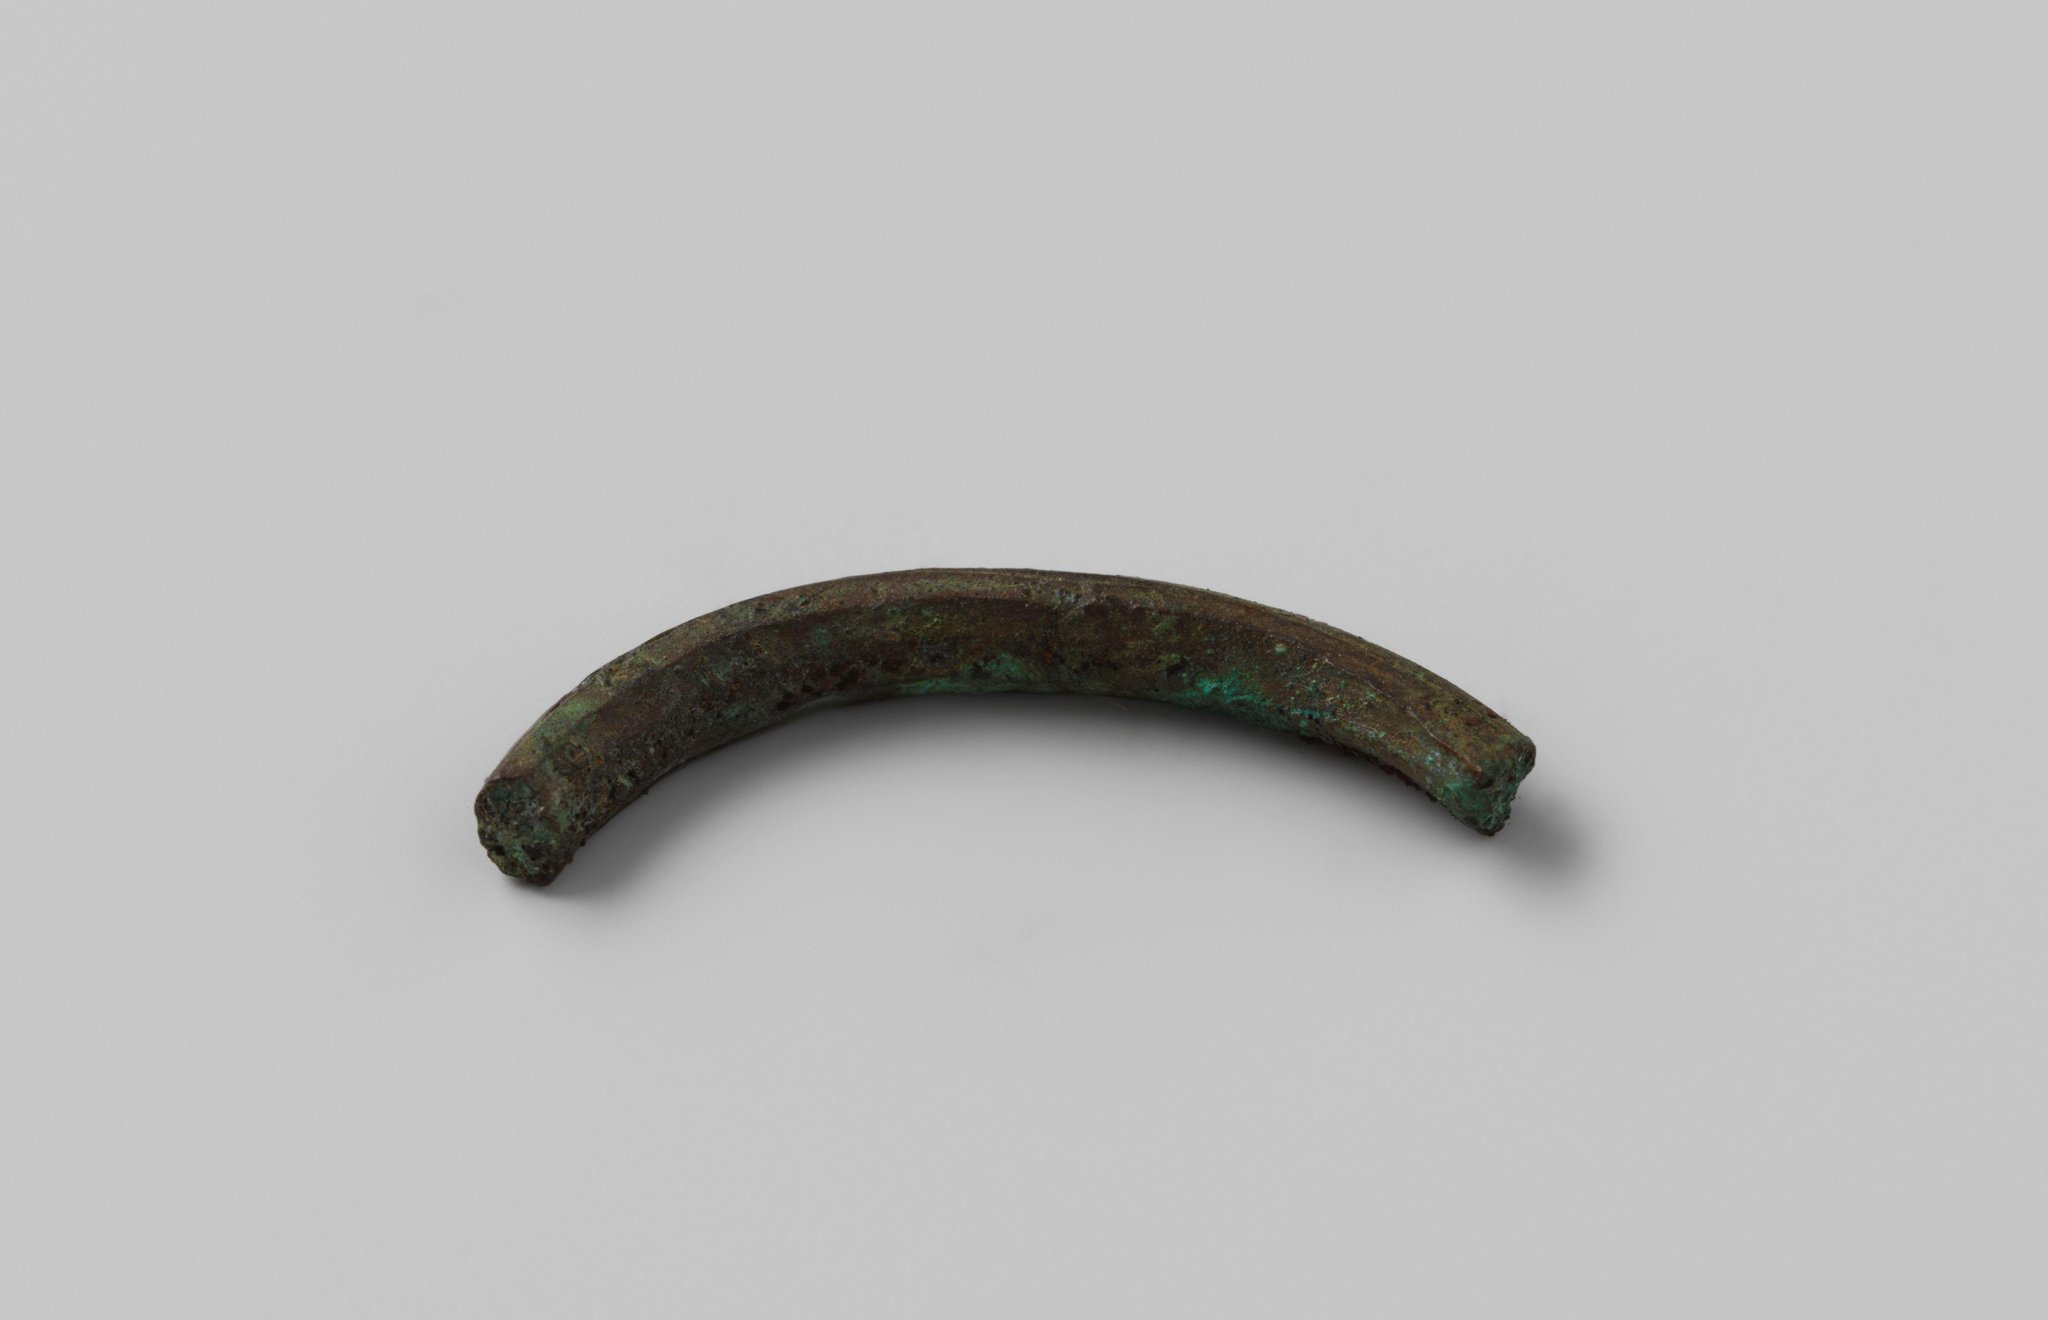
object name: ring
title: Halve ringvormige fragment uit het wrak van de Oost-Indiëvaarder Hollandia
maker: Anonymous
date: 1700-1743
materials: copper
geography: netherlands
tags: verenigde oostindische compagnie, hollandia (schip), annet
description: Varied parts or fragments, rings or ring-shaped fragments; fragm, sim. 80H1.